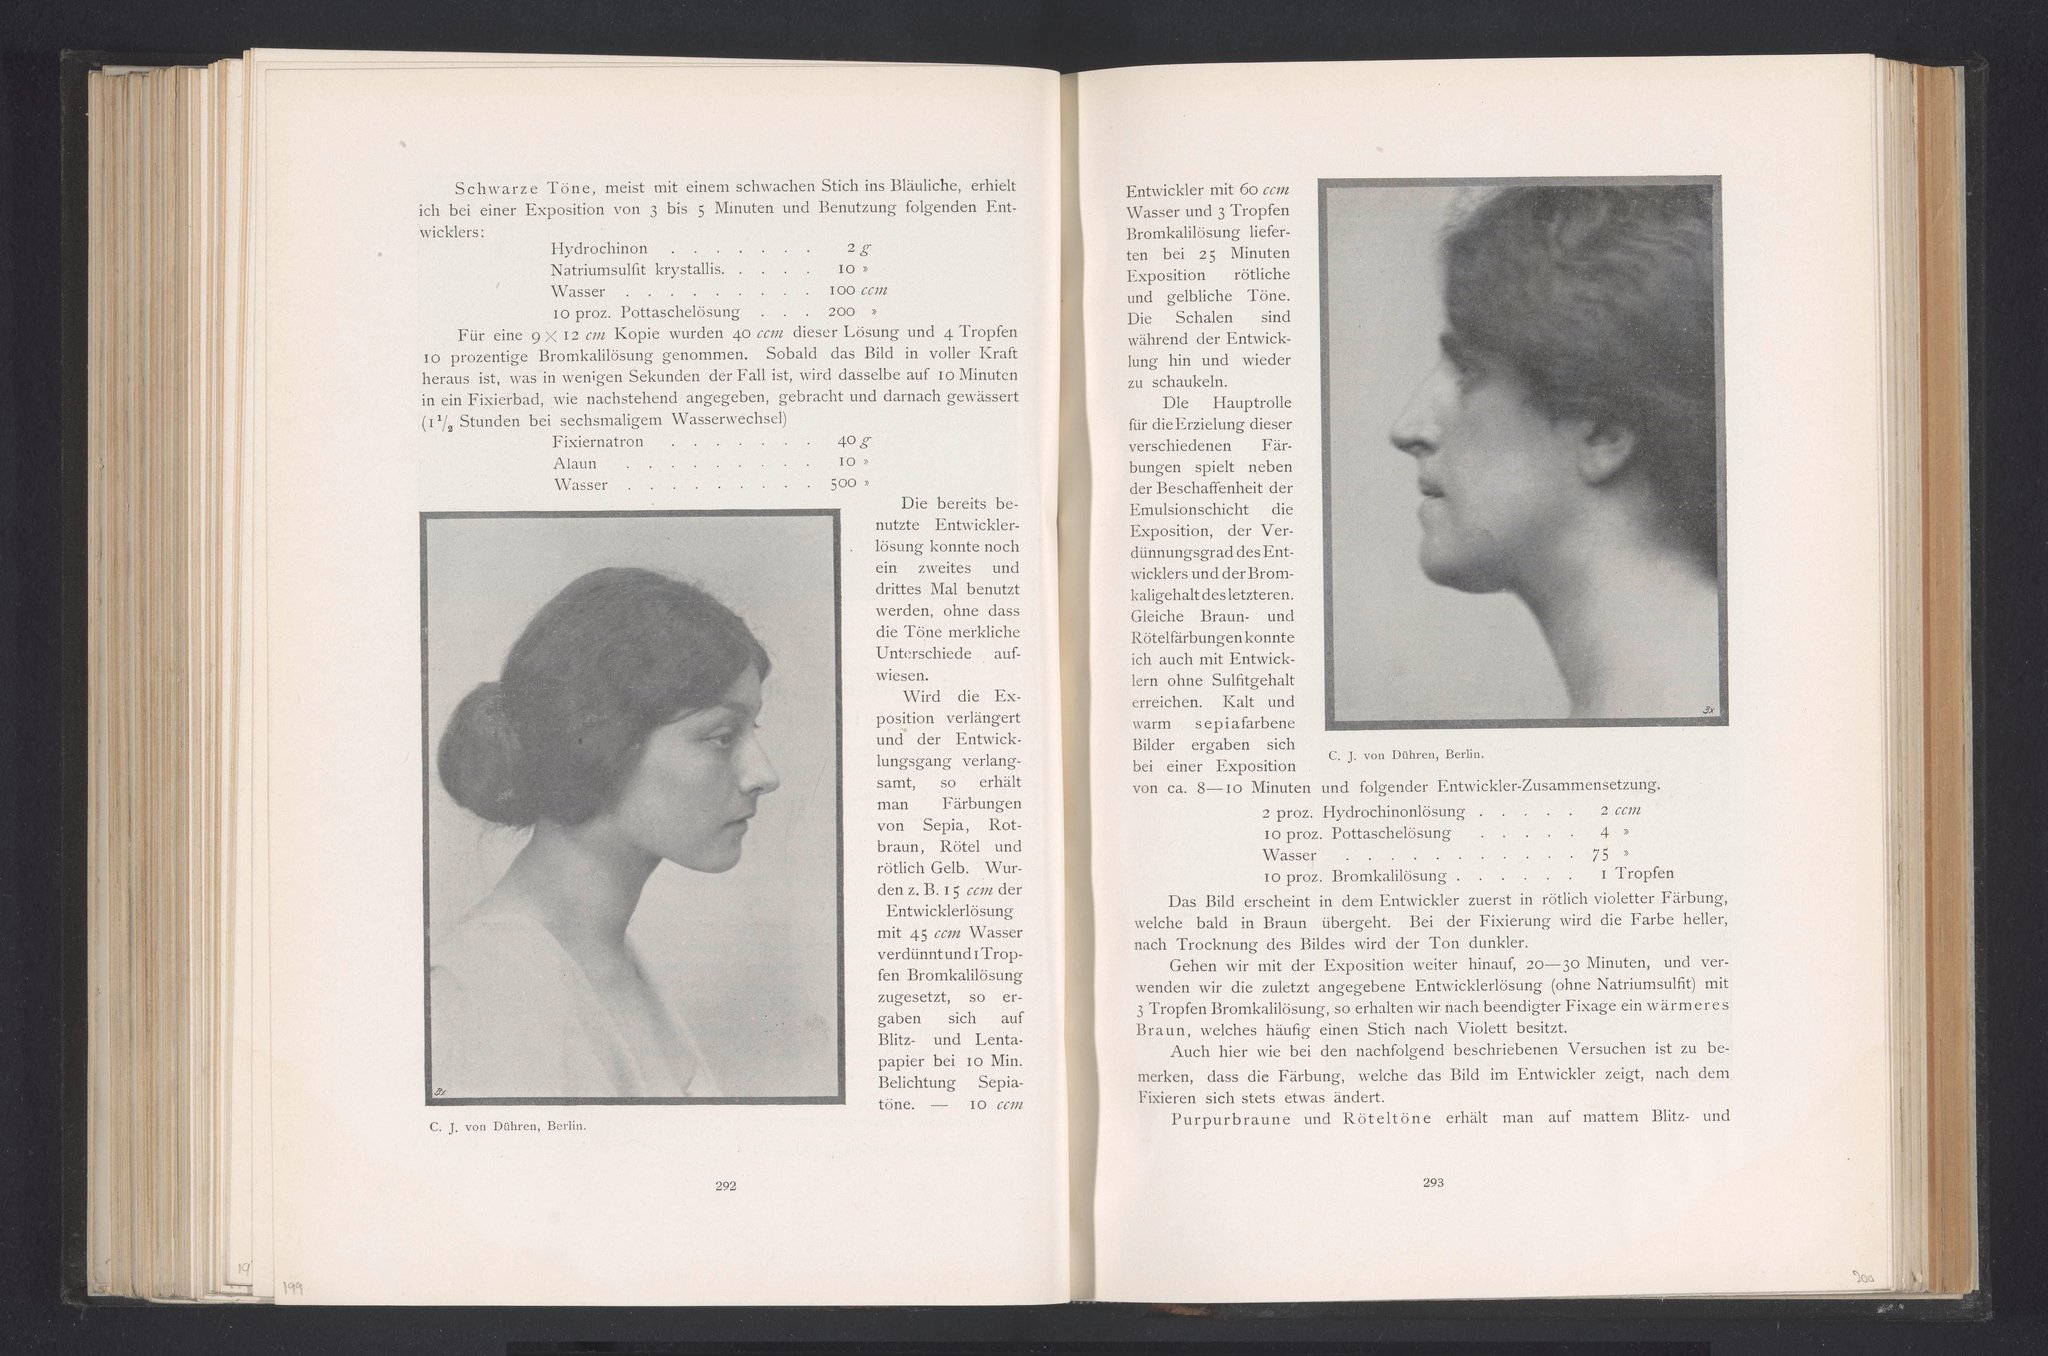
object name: photomechanical print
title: Portret van een onbekende vrouw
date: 1898-1903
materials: paper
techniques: autotype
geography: berlin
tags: historical persons - bb - woman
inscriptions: monogram: ‘BX’